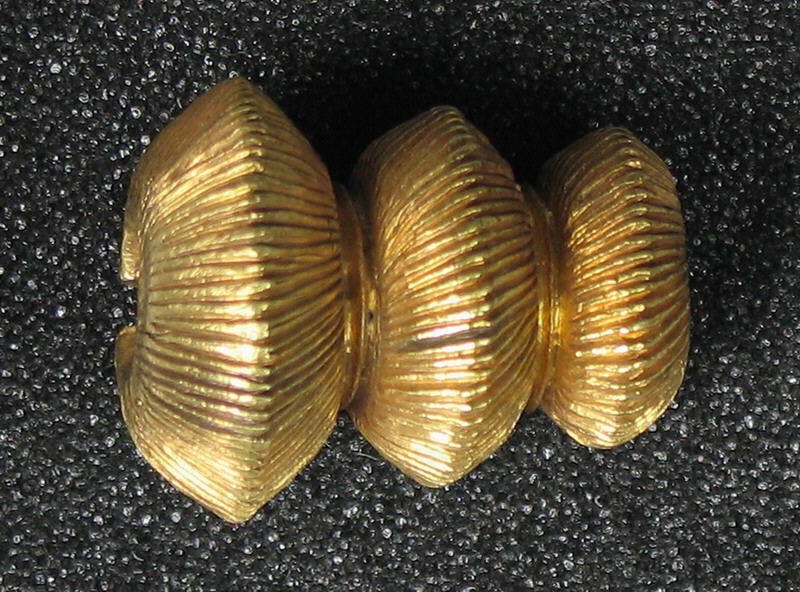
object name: earring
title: Earring, Three Hatched Loops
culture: indonesian, central java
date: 701-1200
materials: gold